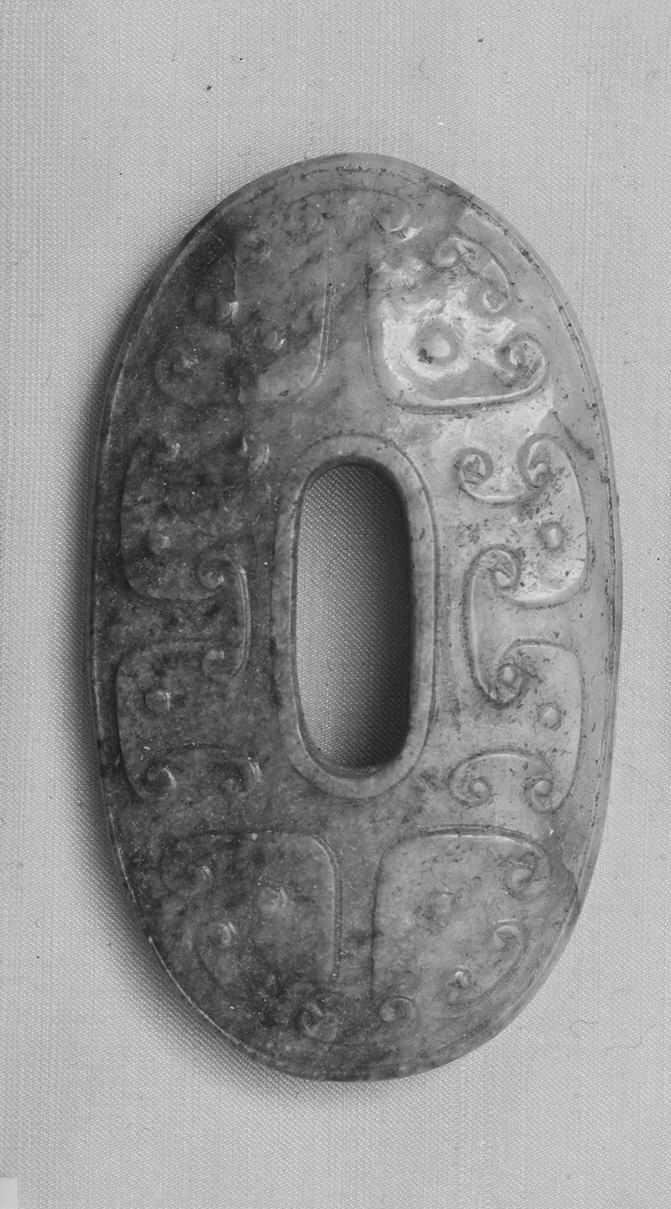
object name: girdle ring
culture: chinese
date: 206 BCE-220 CE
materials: jade